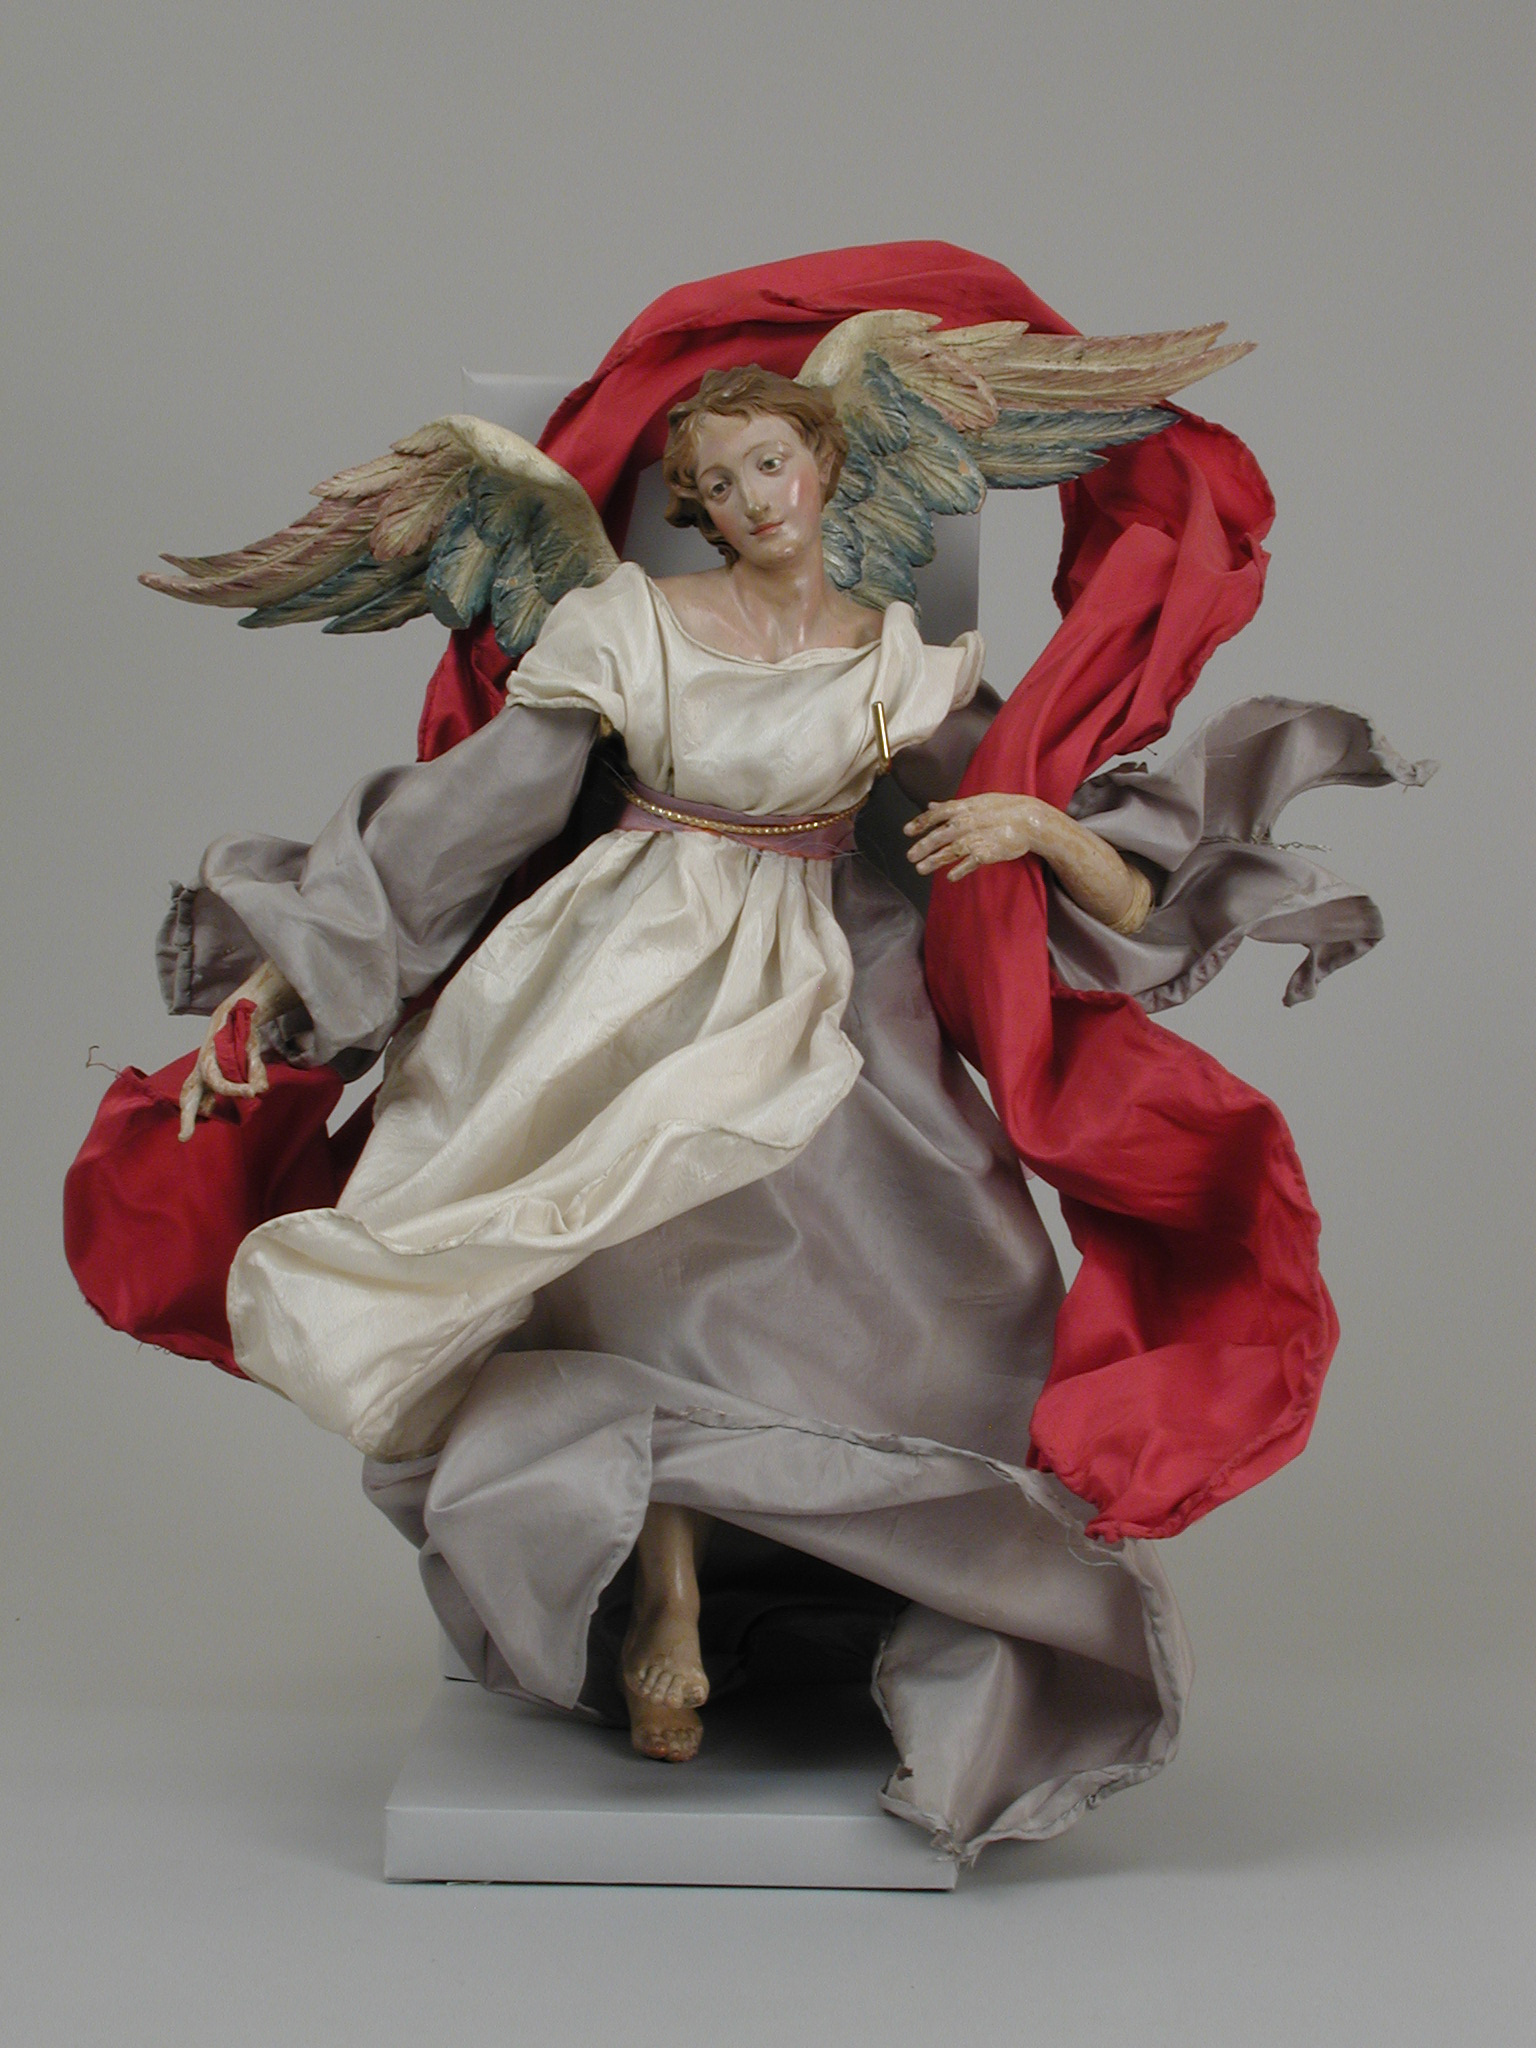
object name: crèche figure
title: Angel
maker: giuseppe sanmartino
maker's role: maker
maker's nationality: italian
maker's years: 1720-1793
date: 1701-1800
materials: terracotta, fiber, metal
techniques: polychrome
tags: angels